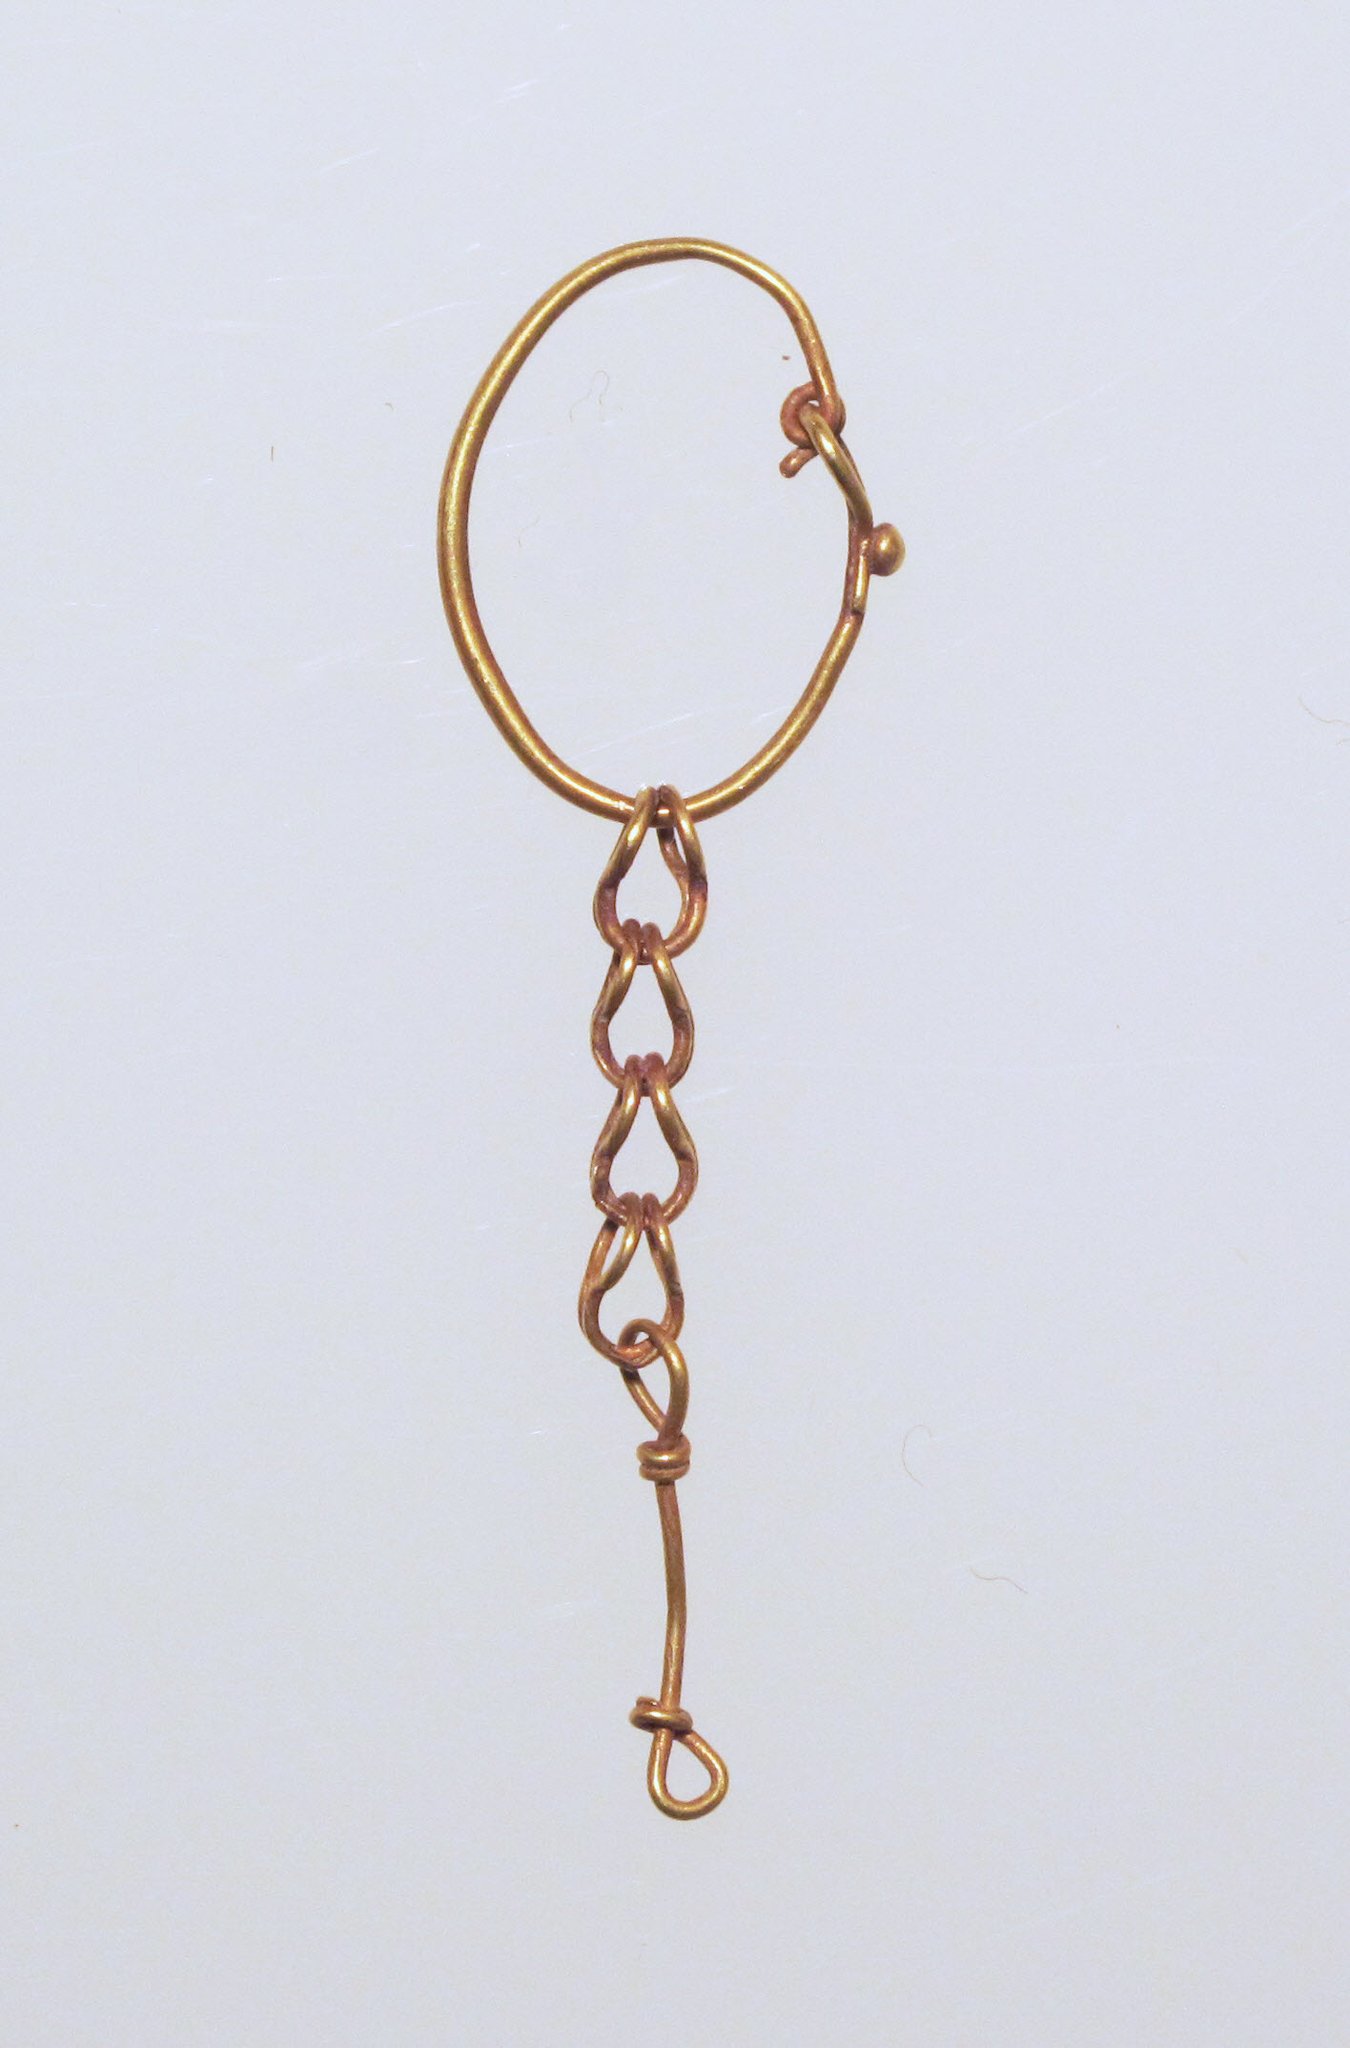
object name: earring with pendant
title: Earring with chain pendant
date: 7000 BCE-330 CE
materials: gold